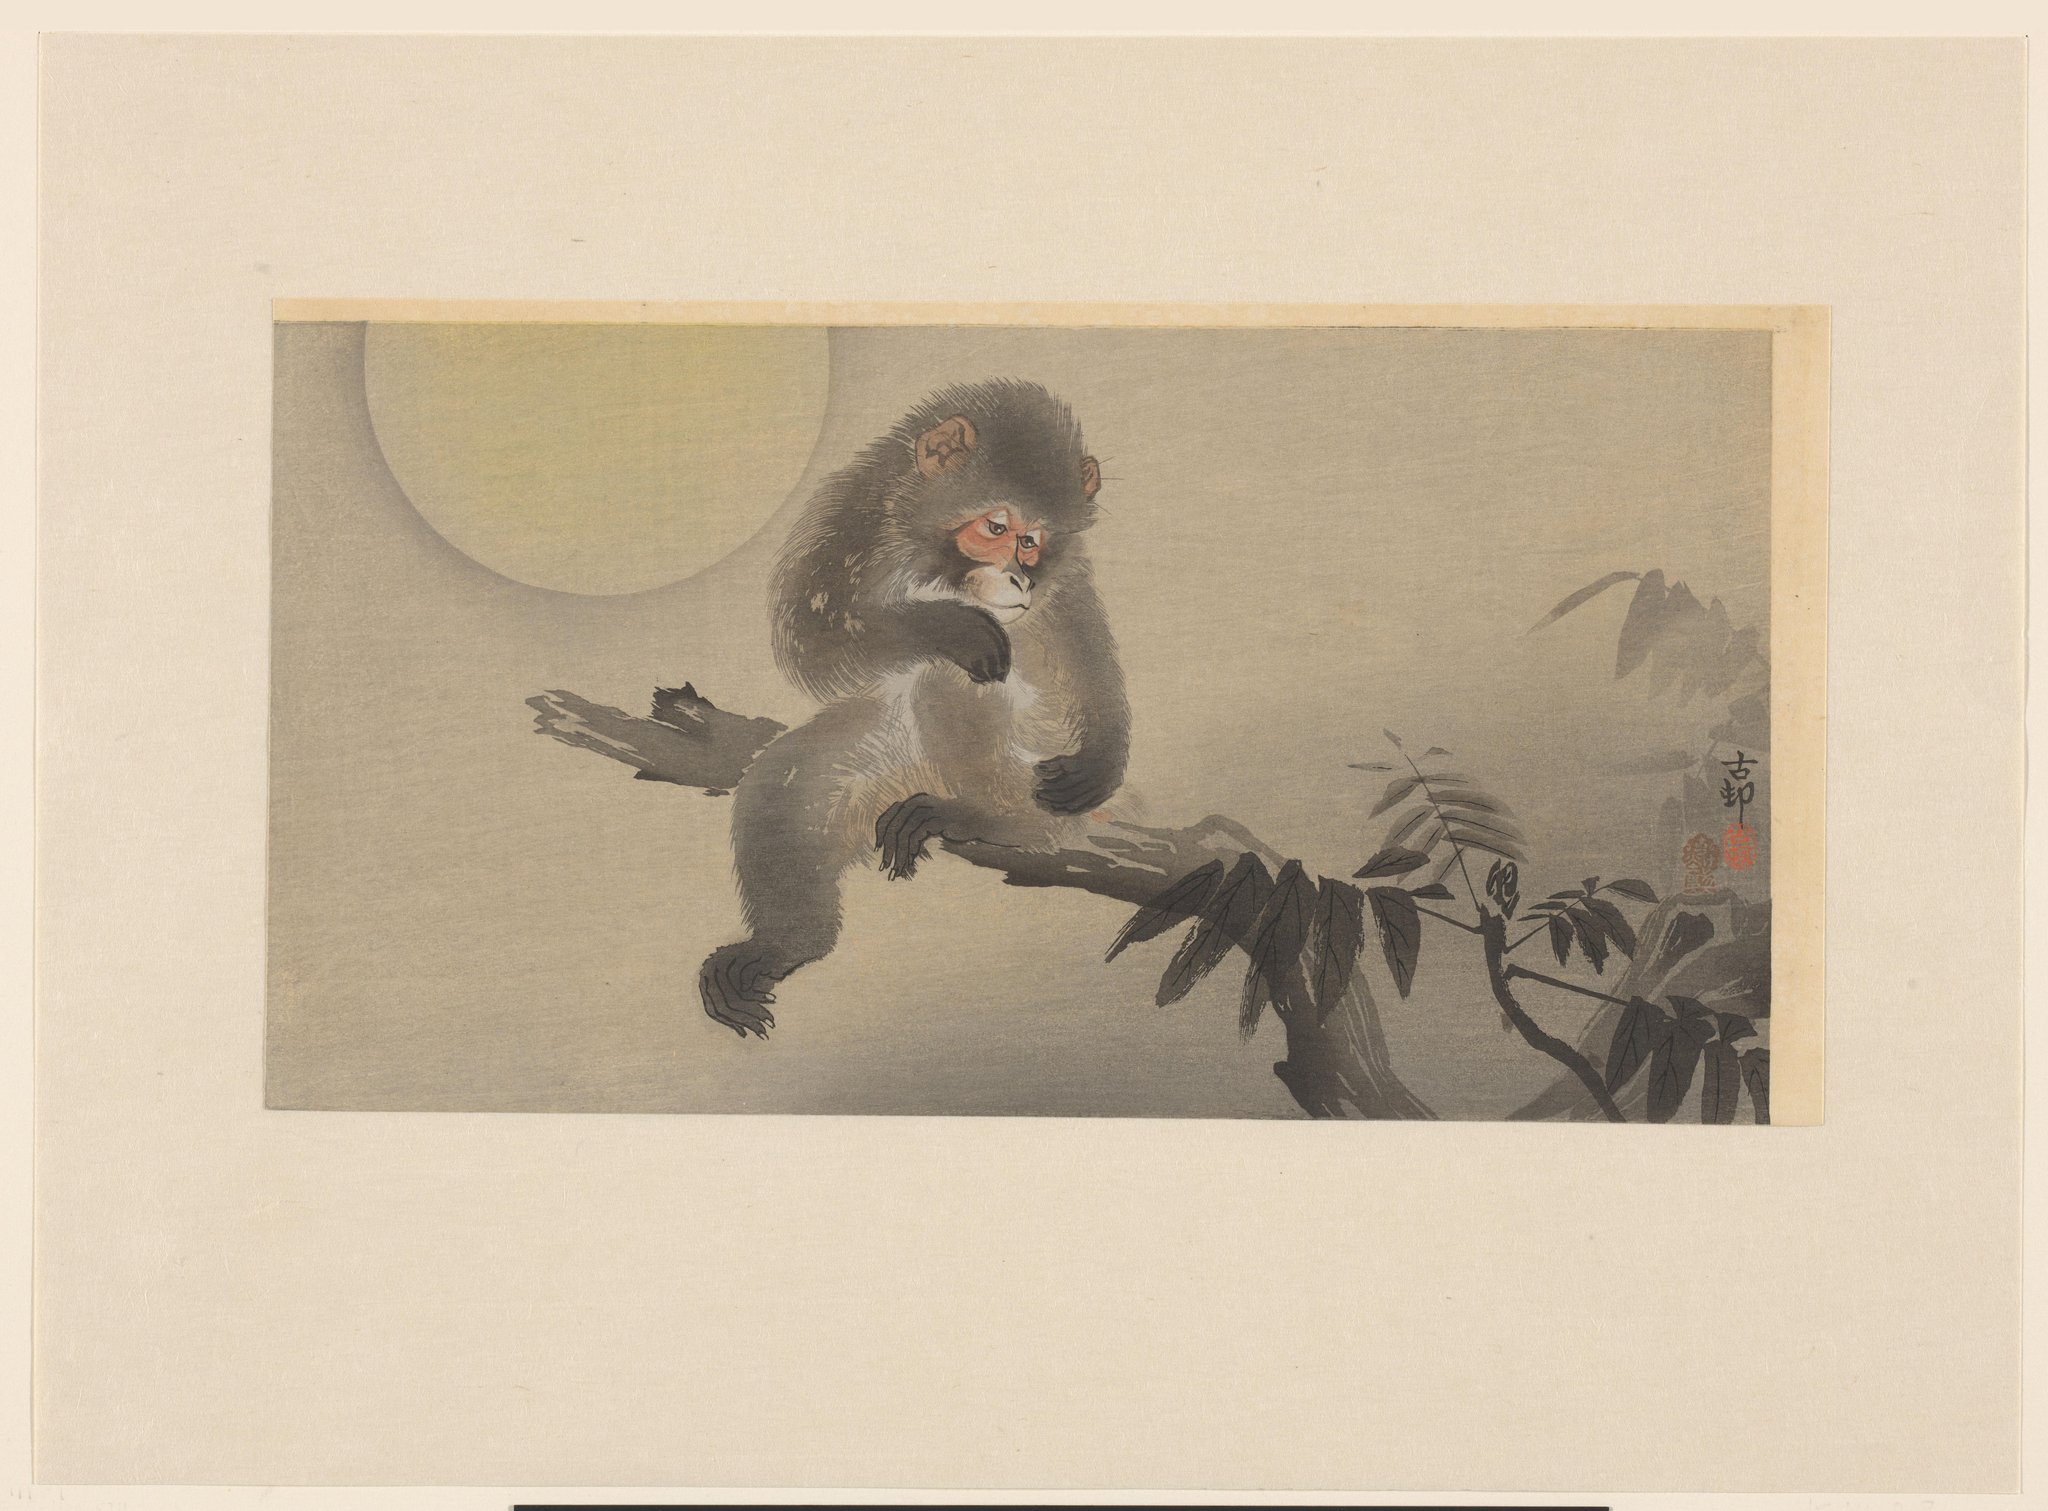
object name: print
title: Aap op tak, bij volle maan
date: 1900-1910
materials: paper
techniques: woodcut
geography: japan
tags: monkeys, apes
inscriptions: collector's mark: Lugt 2228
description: Een aap, zittend op een boomtak, zichzelf vlooiend bij volle maan.